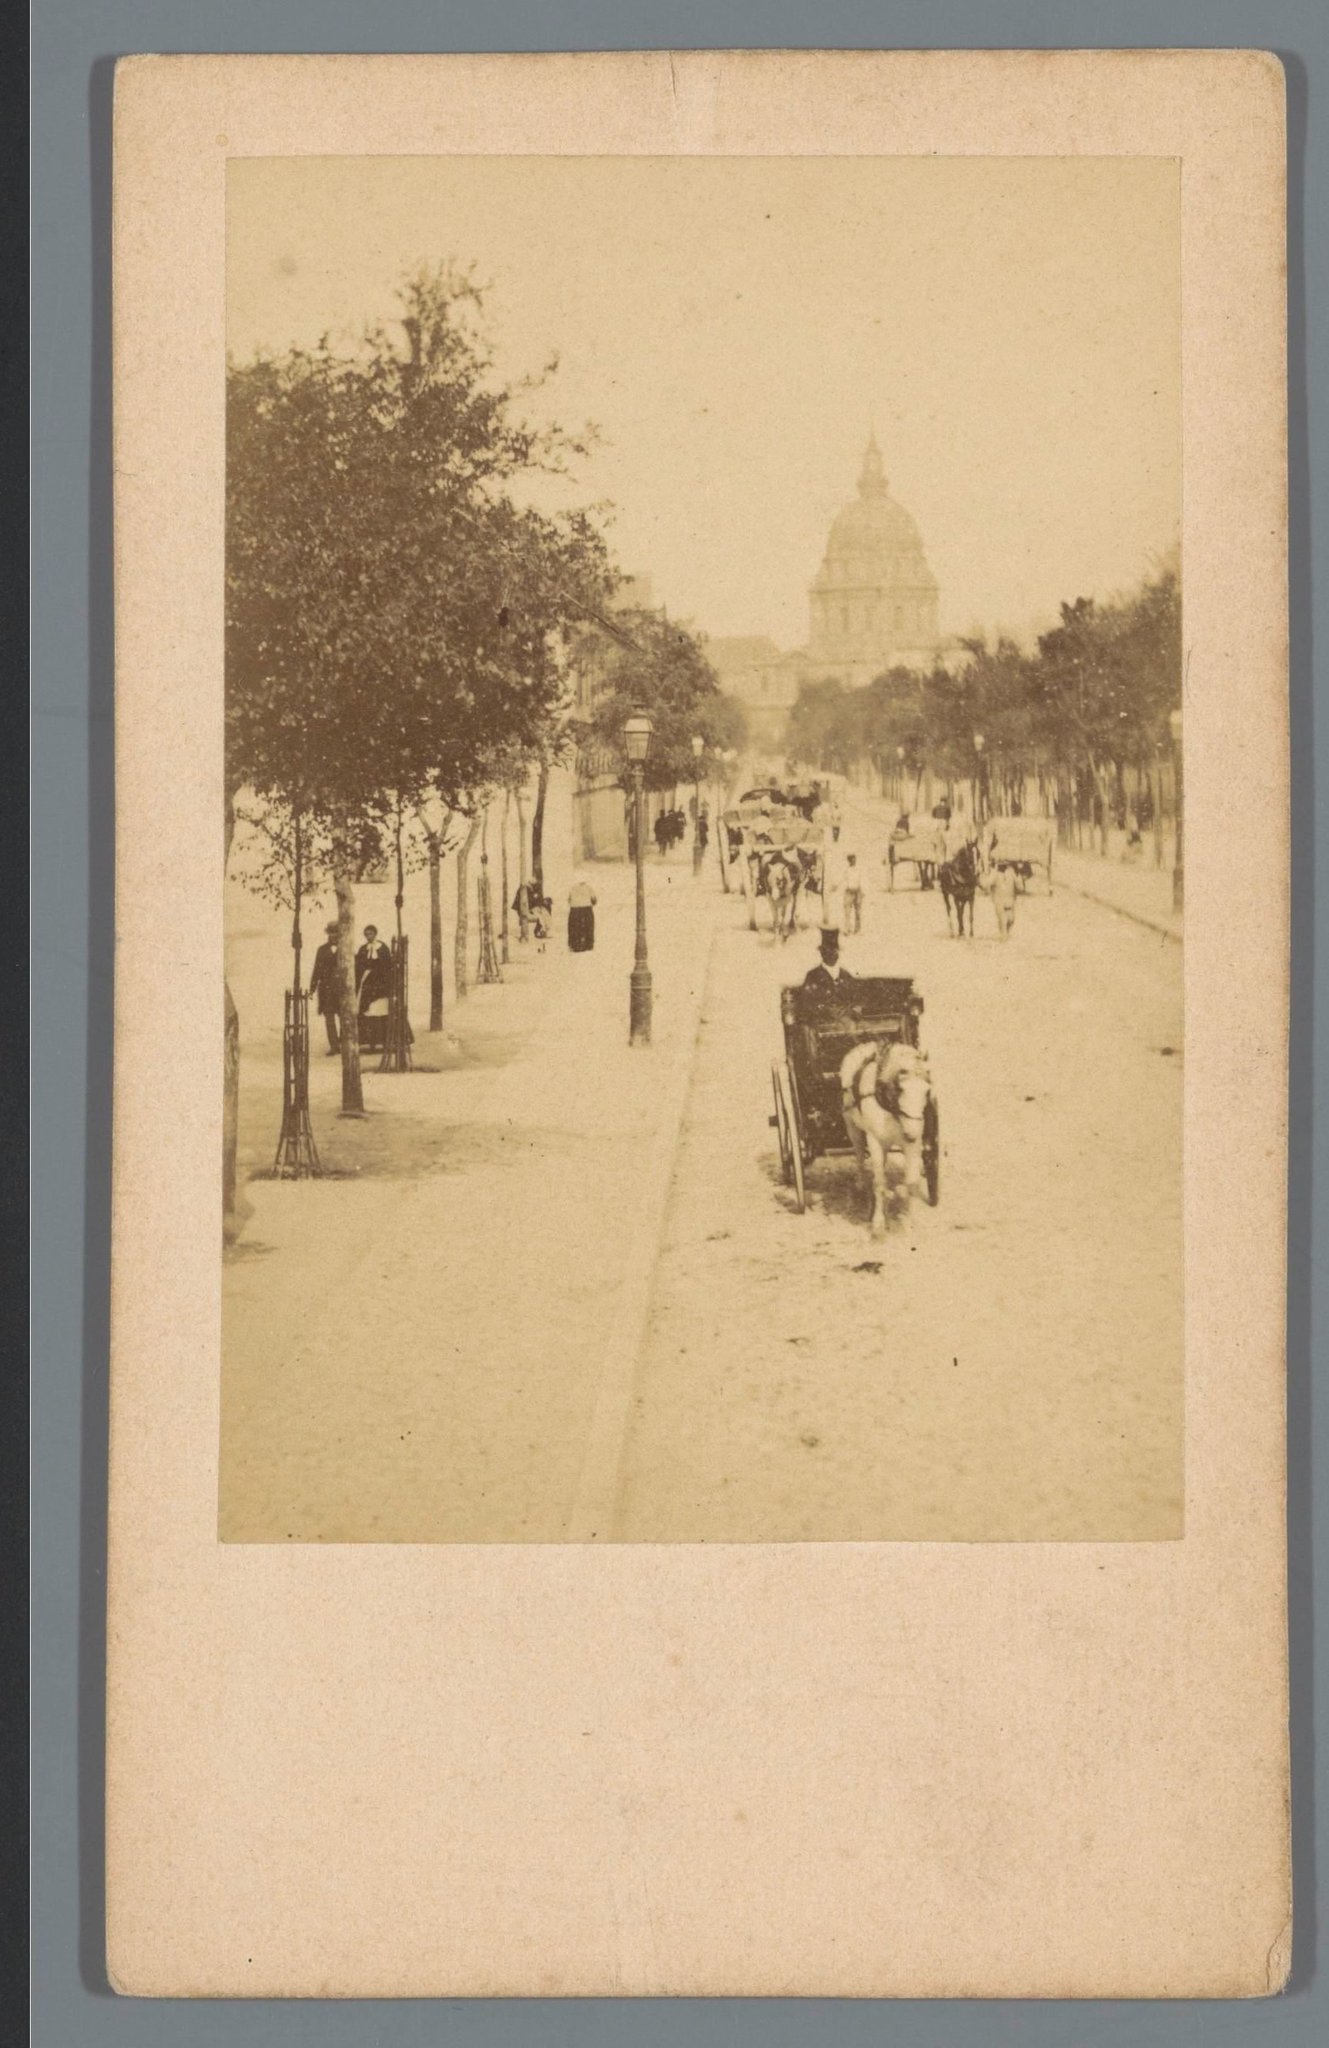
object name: photograph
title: Bd. des Invalides, Paris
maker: Anonymous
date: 1855-1885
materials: cardboard, paper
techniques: albumen print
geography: paris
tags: four-wheeled vehicle drawn by one animal, avenue, boulevard, promenade, esplanade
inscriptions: number: ‘127’